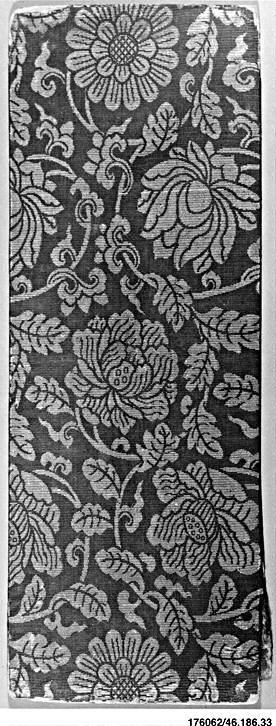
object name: sutra cover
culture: chinese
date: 1501-1600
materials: silk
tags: flowers